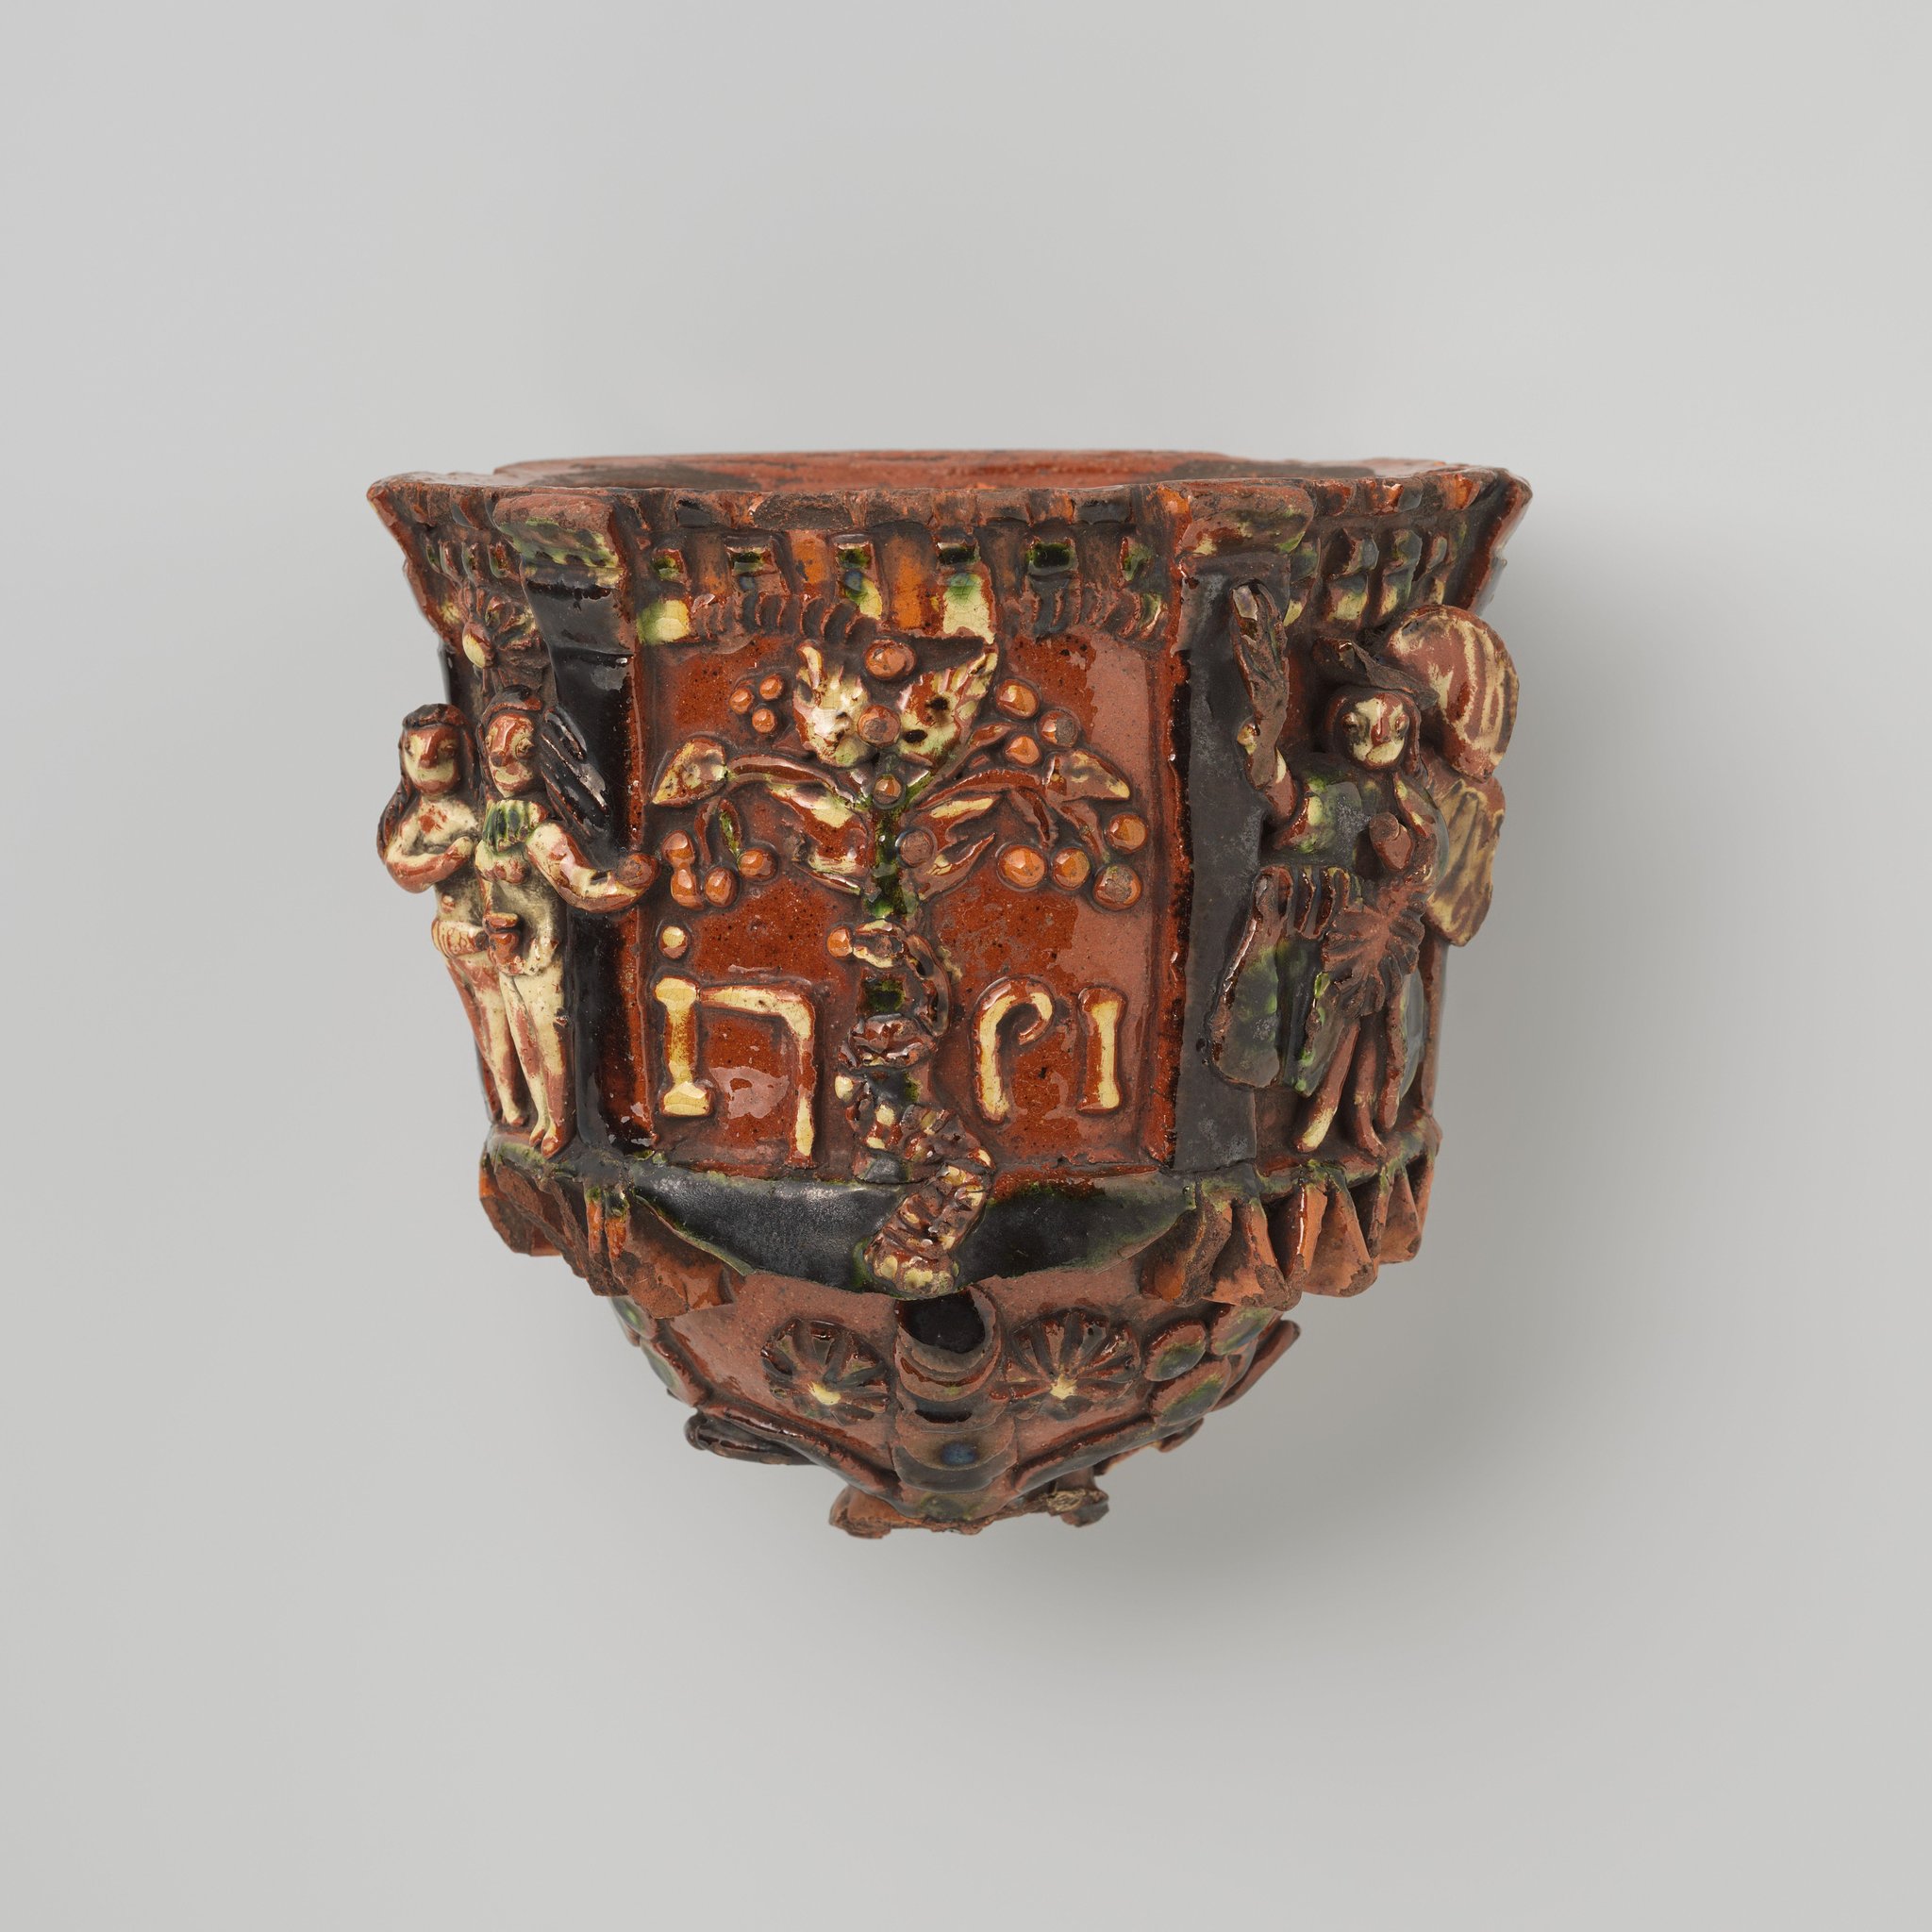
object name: holy water stoup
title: Wijwaterbak van loodglazuuraardewerk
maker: Anonymous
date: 1791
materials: earthenware, glaze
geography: limburg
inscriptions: date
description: Wijwaterbak van loodglazuuraardewerk, in de vorm van een preekstoel. Op de bak is een afbeelding in reliëf van Eva die de appel van de boom plukt. Naast Eva staat Adam en om de boom is de slang gedraaid.